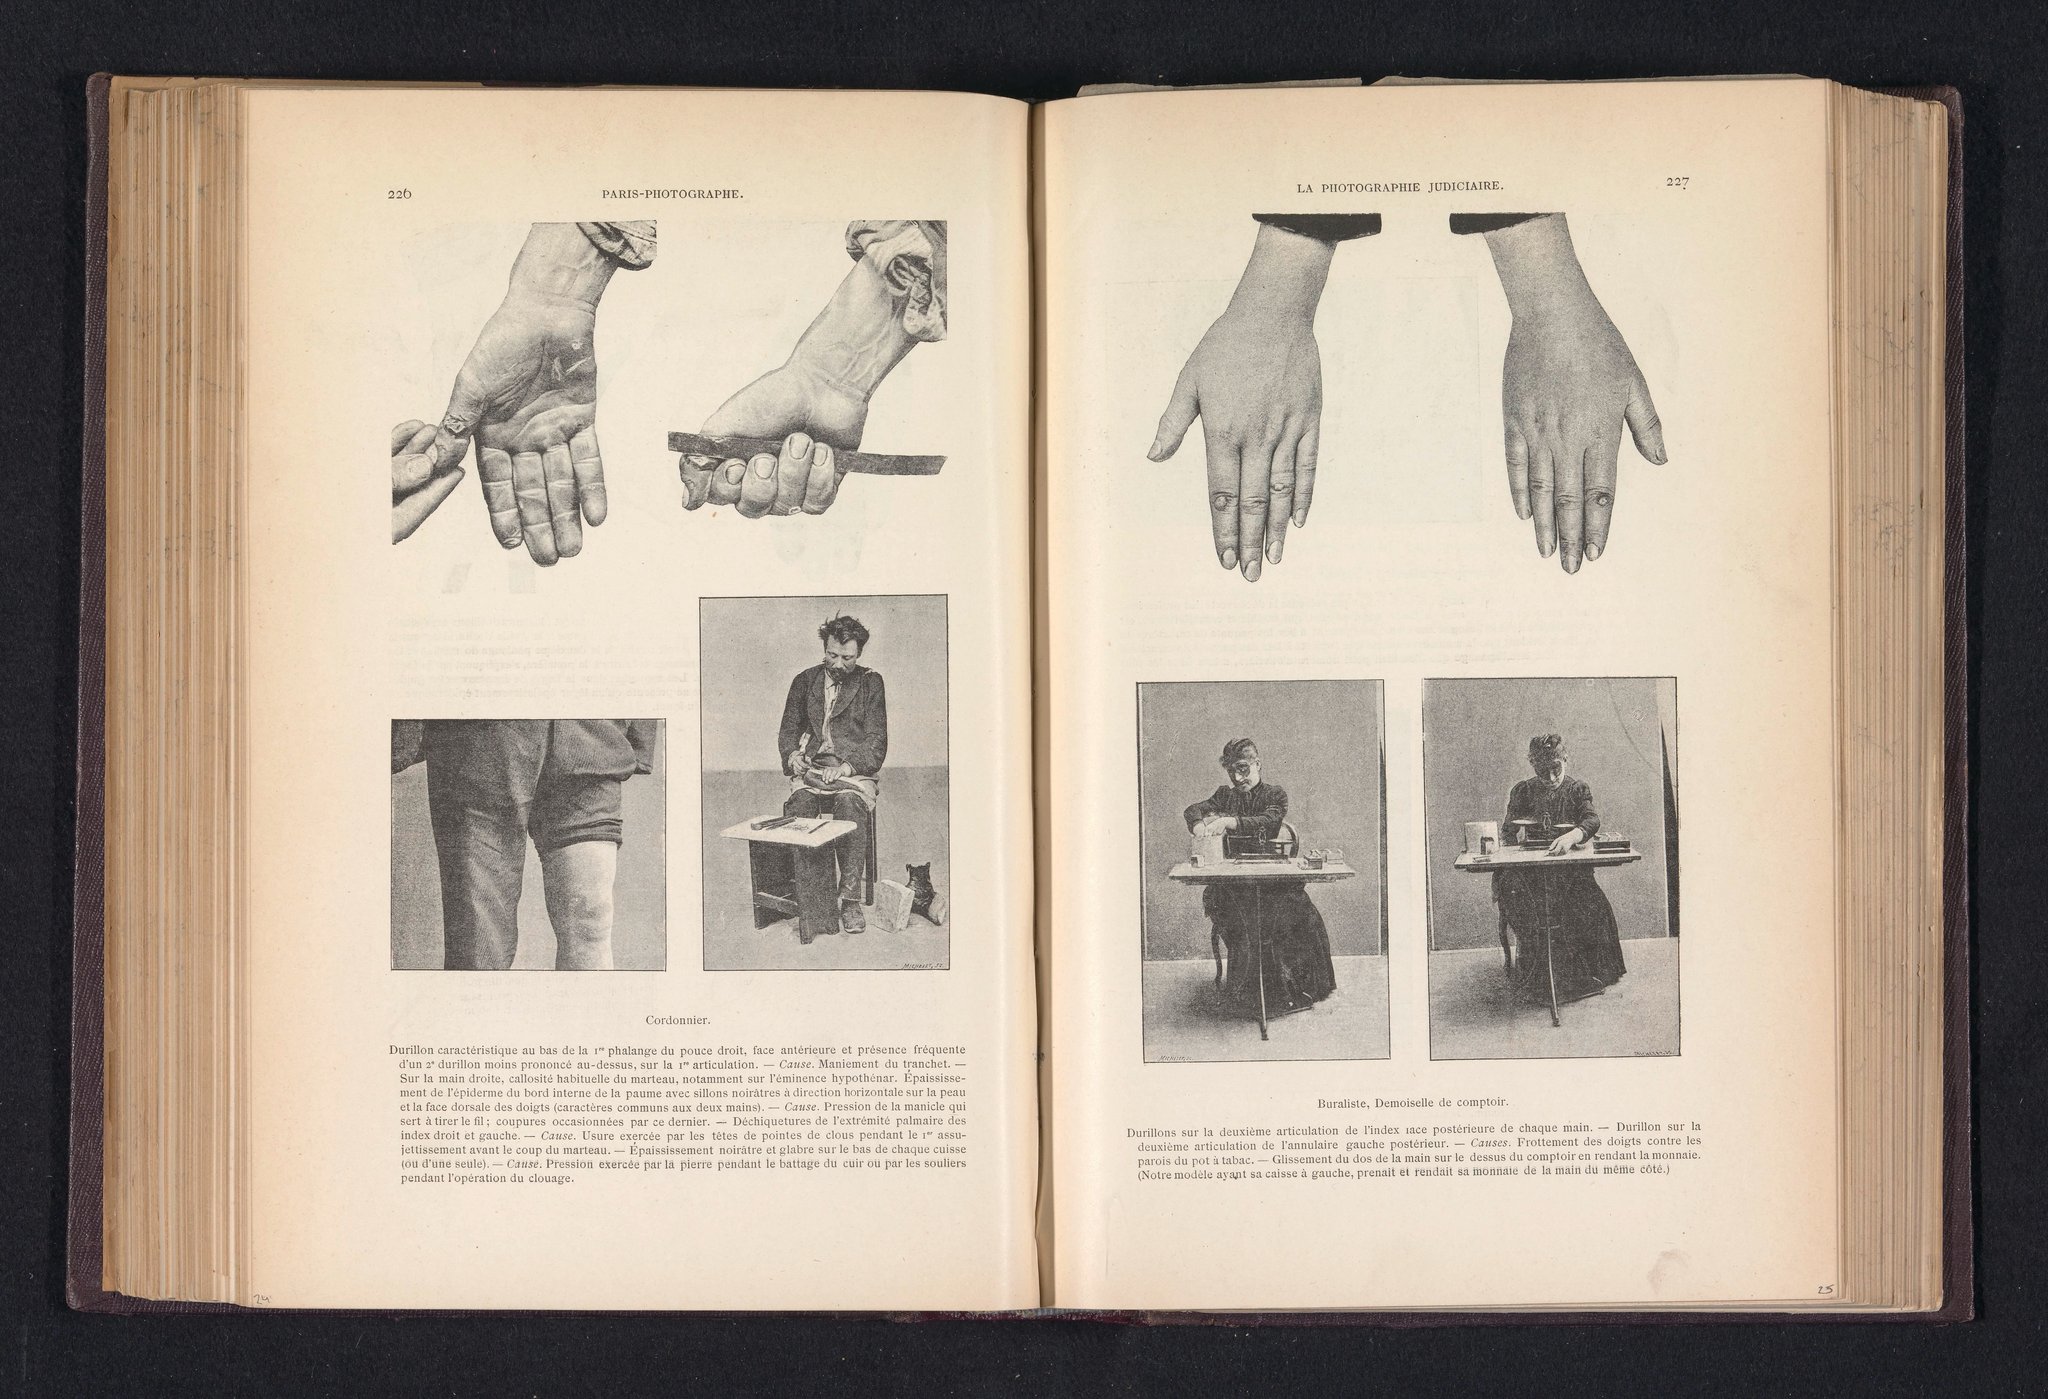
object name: page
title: Cordonnier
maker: Anonymous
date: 1881-1891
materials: paper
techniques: autotype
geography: france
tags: hand, legs, shoe-maker, cobbler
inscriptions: inscription: ‘Durillon charactéristique (...) l'opération du clouage.’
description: Boven twee handen met beschadigingen en een instrument, onder een been en een schoenmaker.